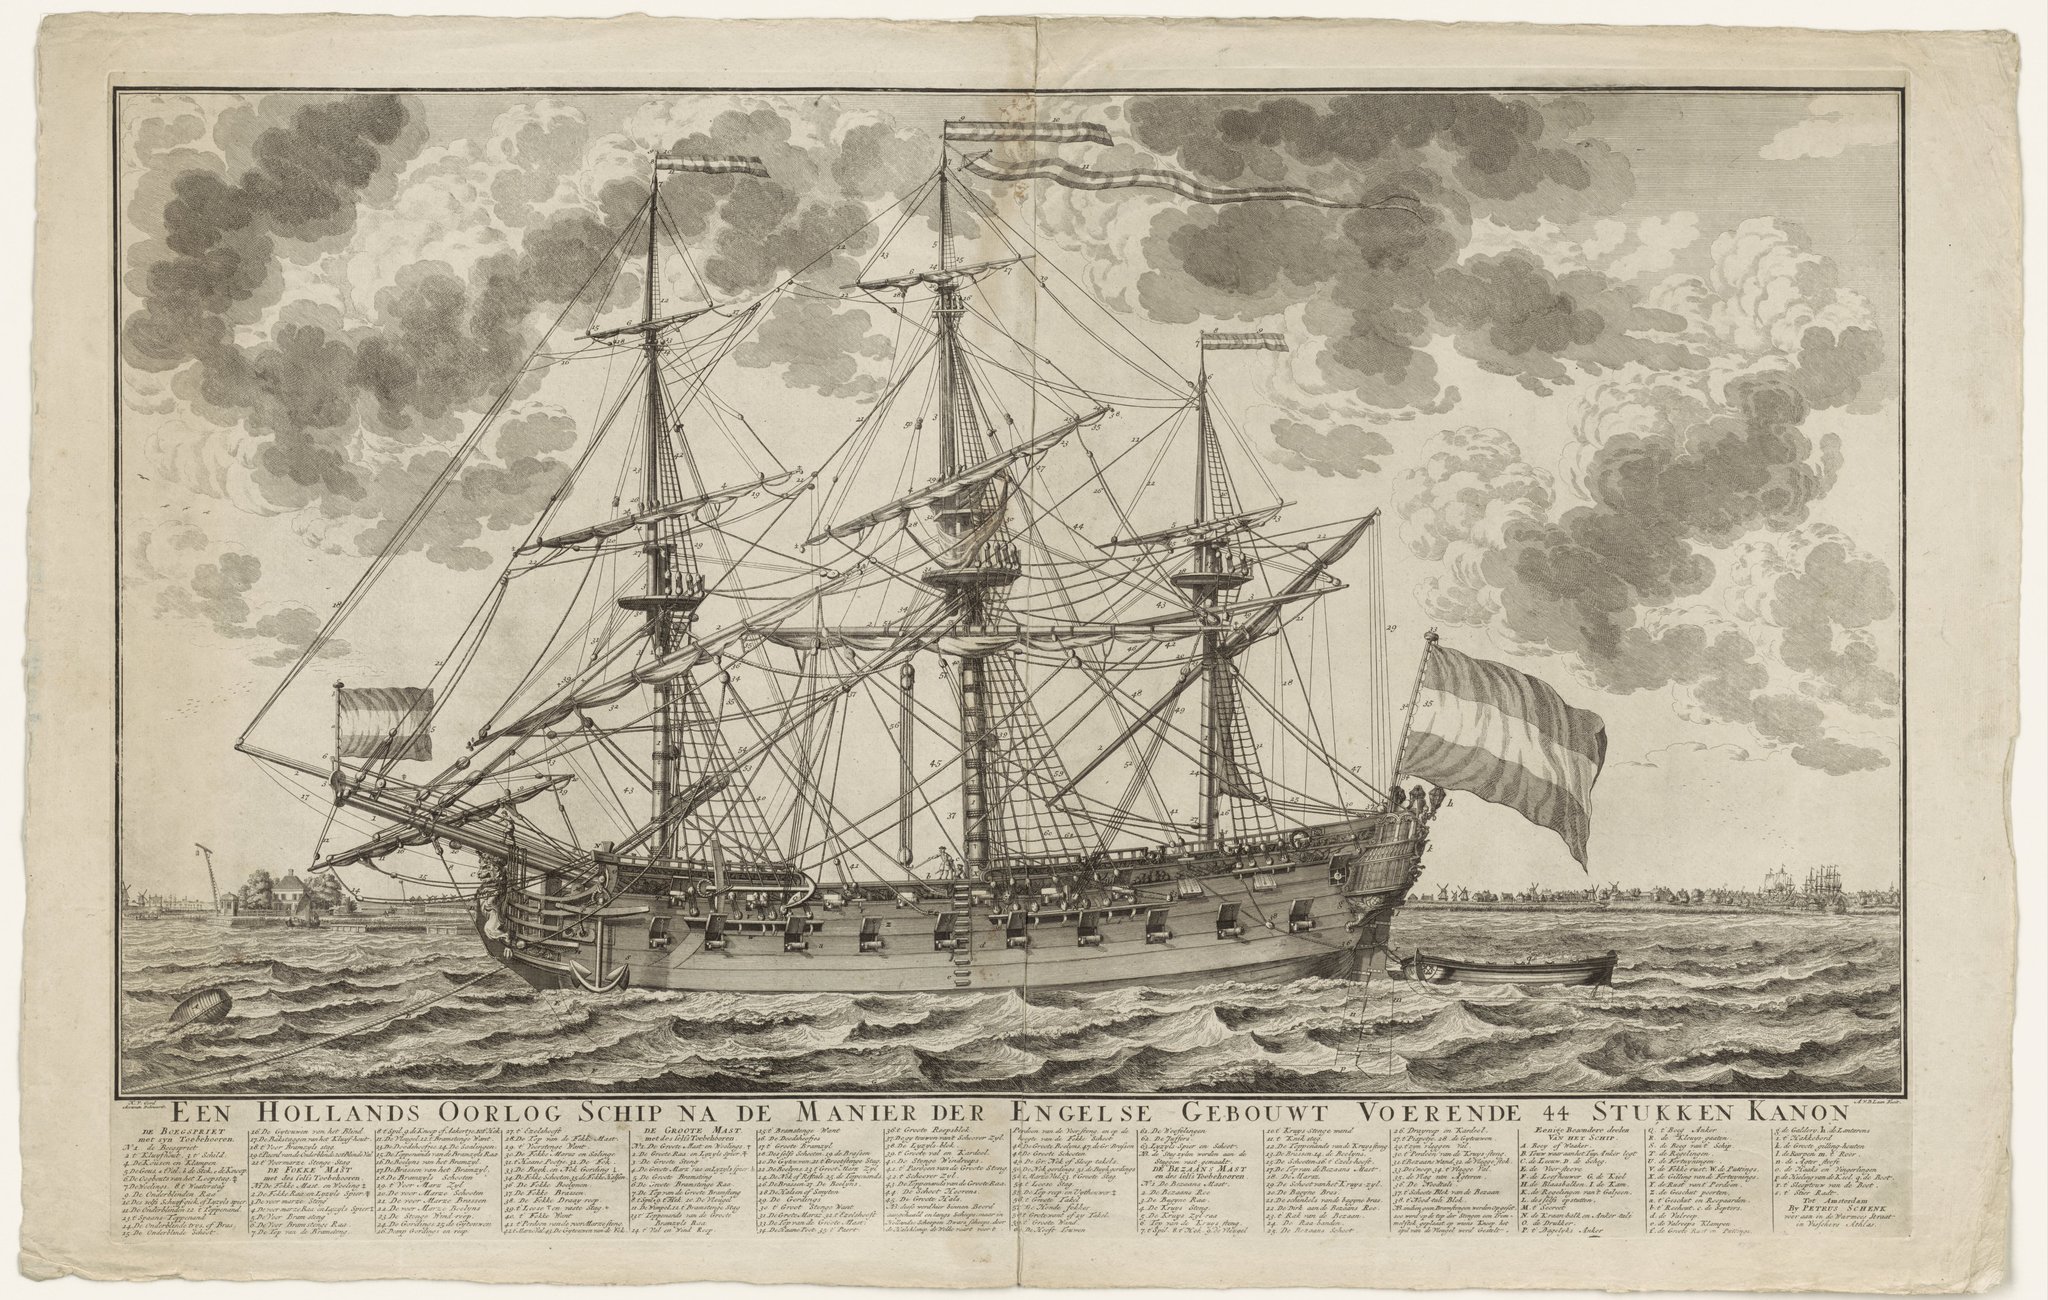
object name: print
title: Een Hollands Oorlog Schip na de Manier der Engelse Gebouwt Voerende 44 Stukken Kanon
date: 1710-1742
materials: paper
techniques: etching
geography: amsterdam